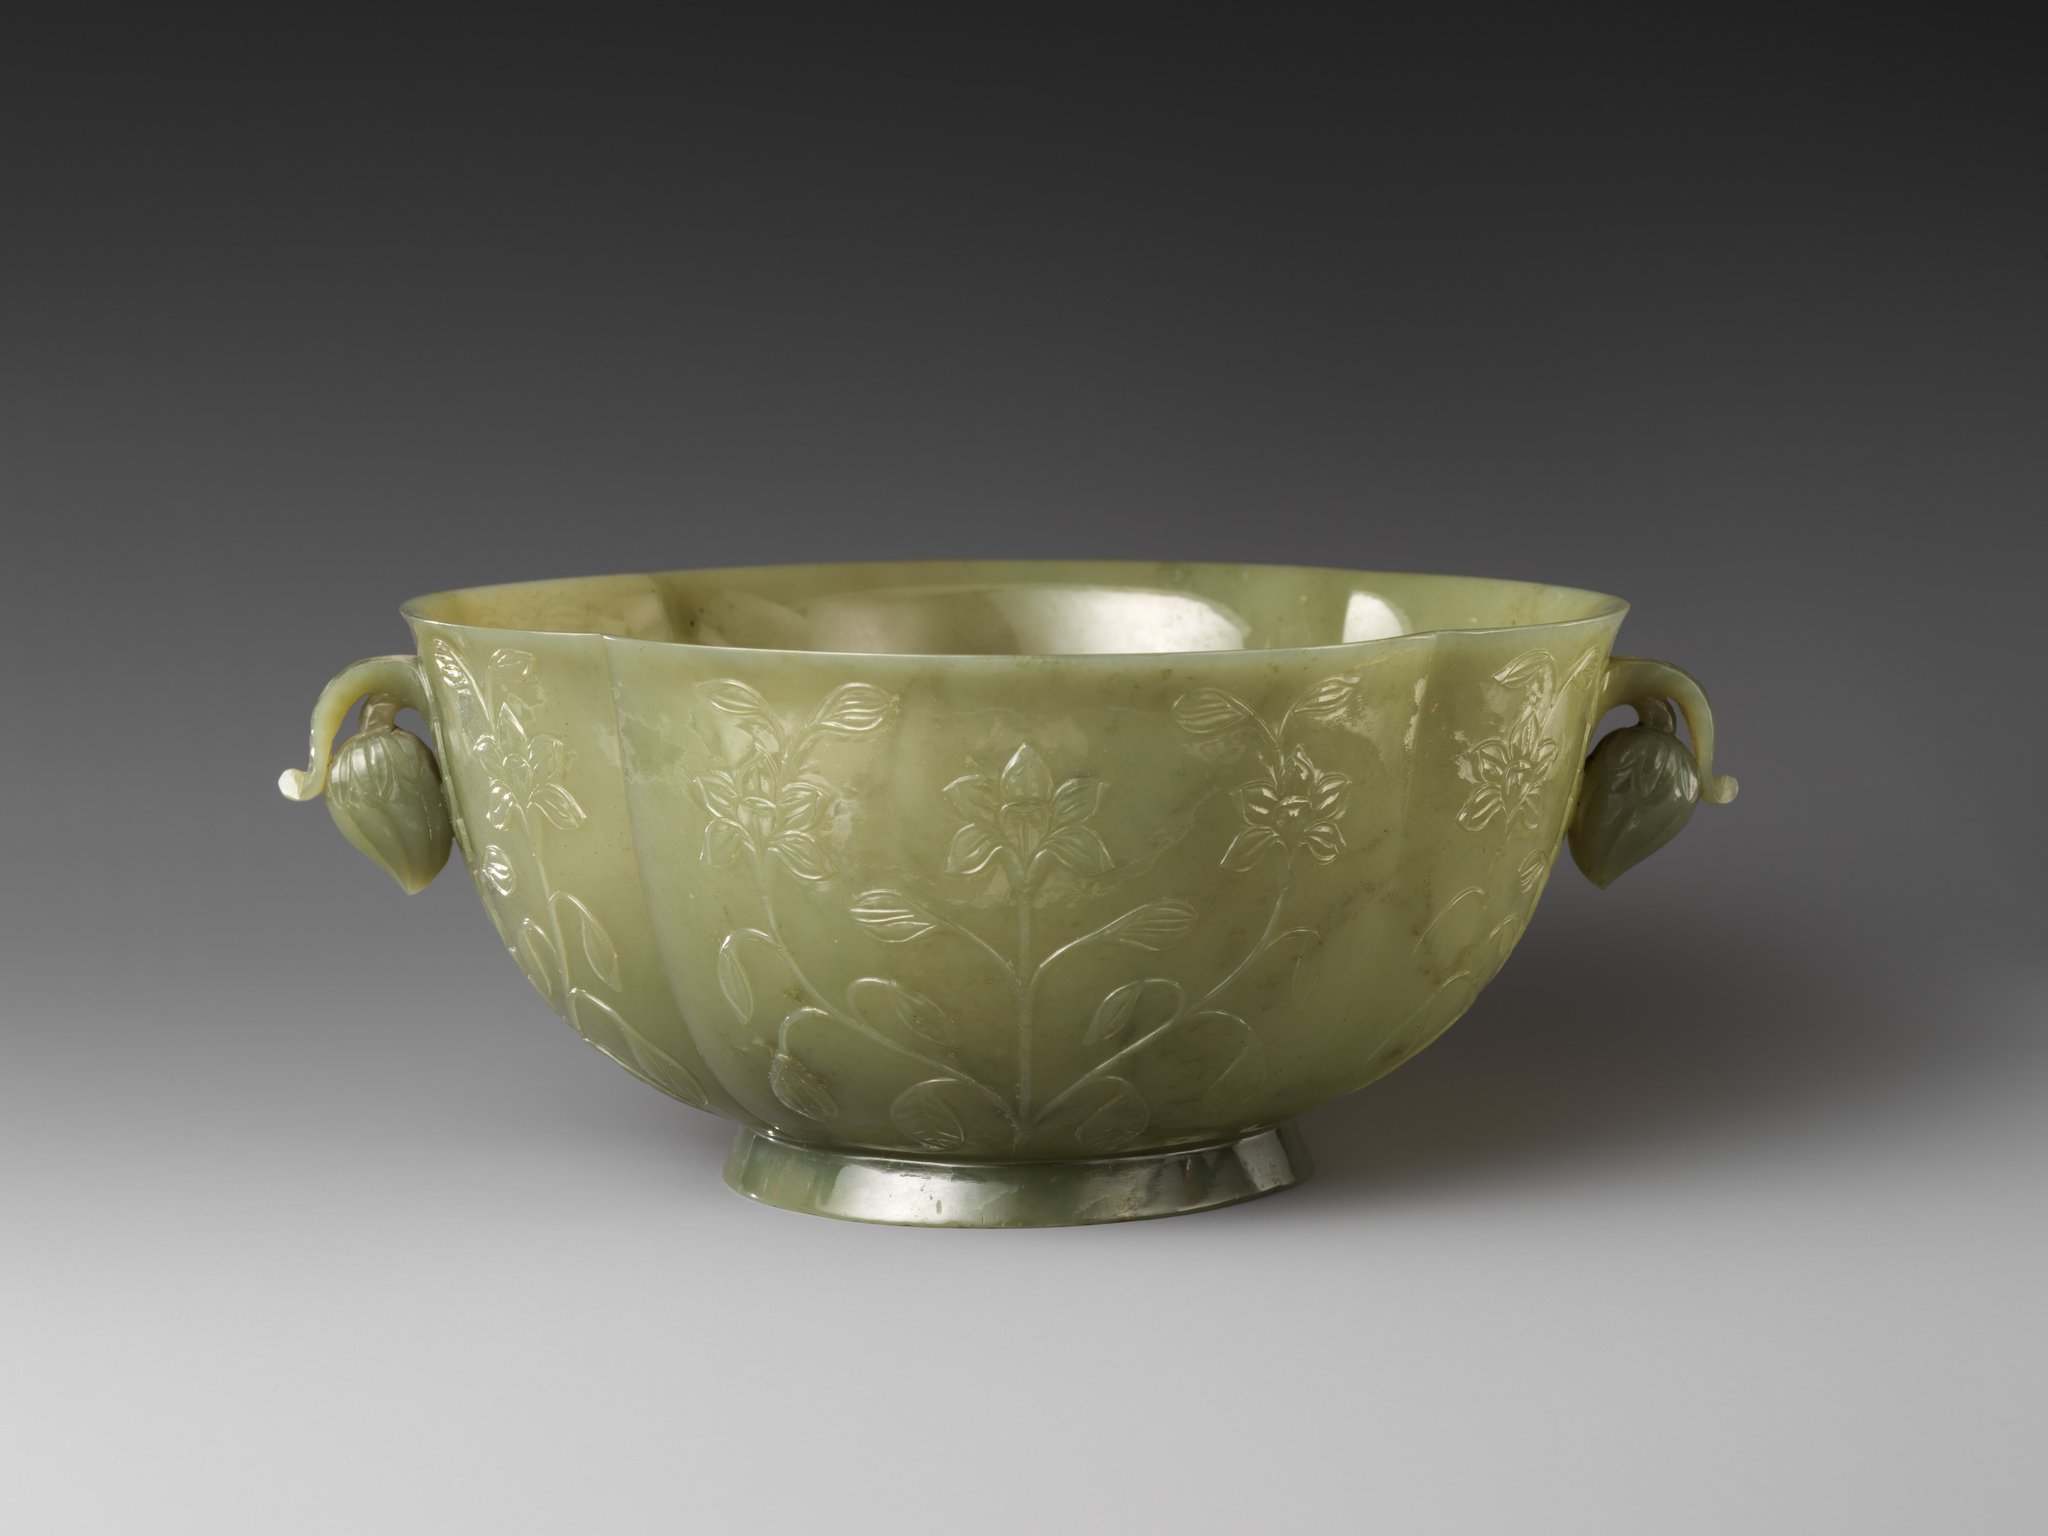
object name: bowl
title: Bowl with floral design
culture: indian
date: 1701-1800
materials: jade